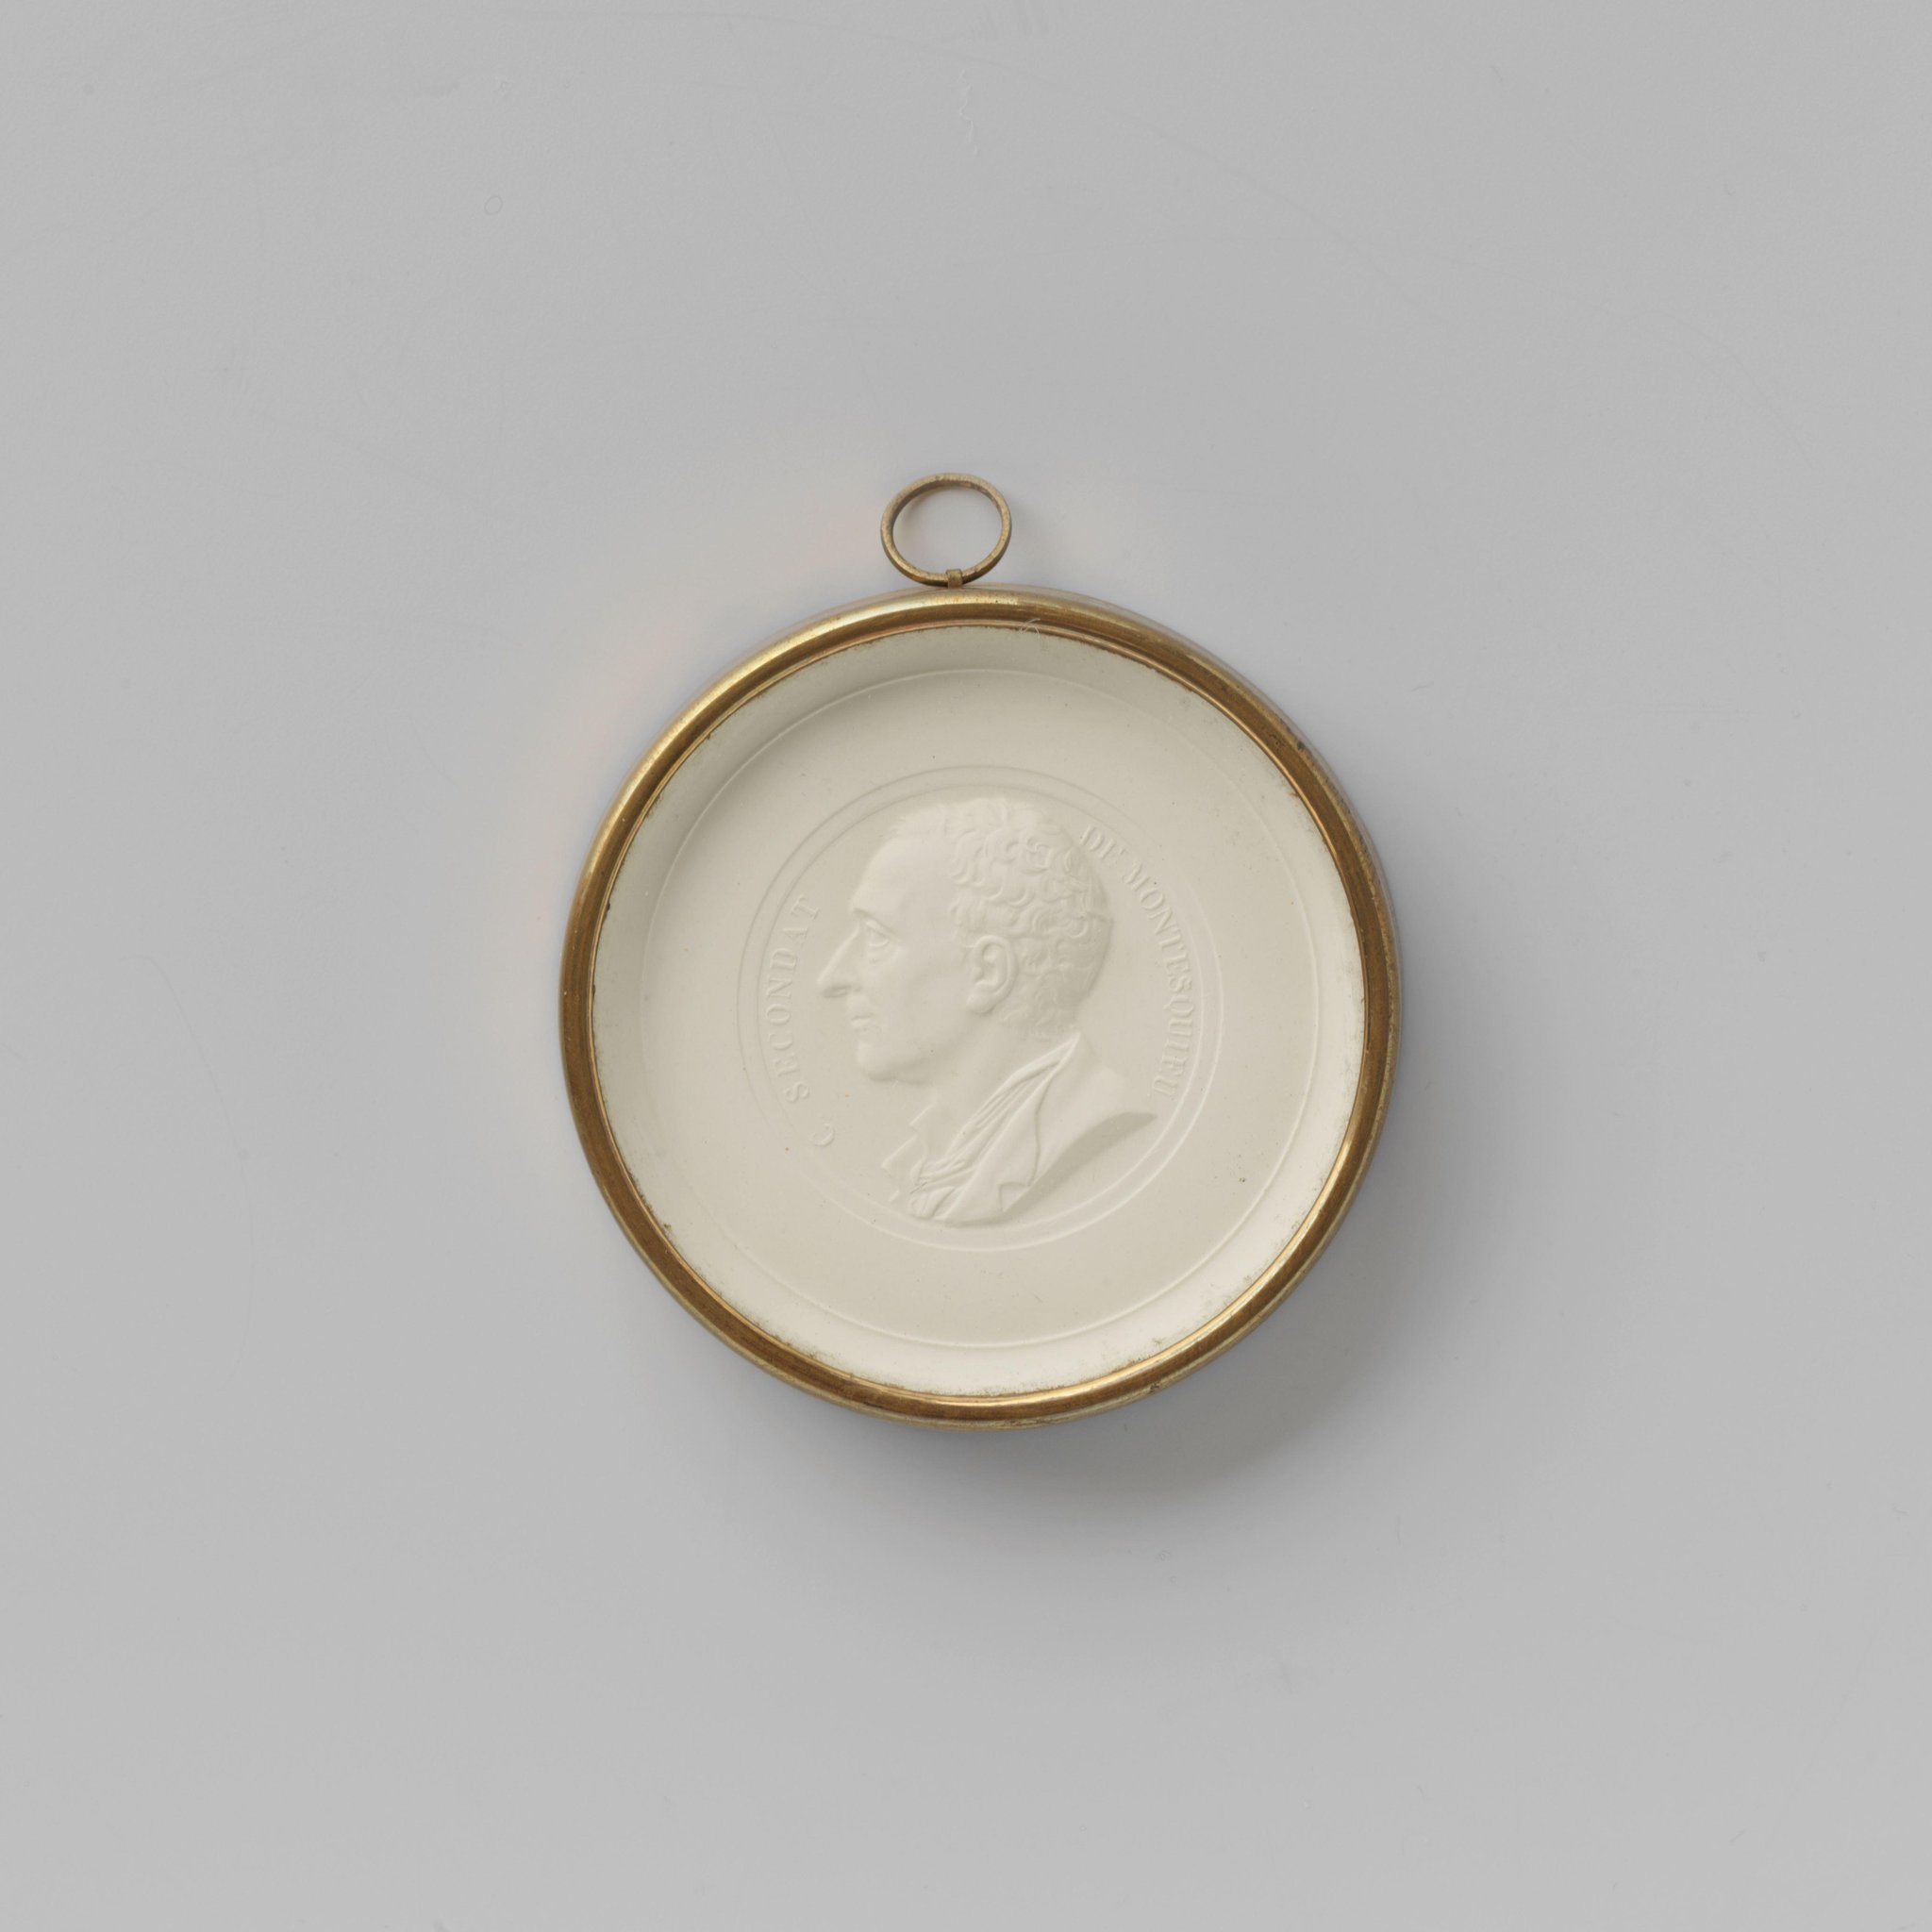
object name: locket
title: Antonio Canova, beeldhouwer te Rome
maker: gottfried eichler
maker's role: draughtsman, painter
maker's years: 1677-1757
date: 1687-1757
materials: brass, glass, gypsum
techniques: casting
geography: berlin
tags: venice, sculptor, antonio canova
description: Eenzijdig medaillon in messing ring achter glas aan draagoog en draagring. Voorzijde: borststuk man naar links binnen omschrift. Keerzijde: etiket met opschrift.